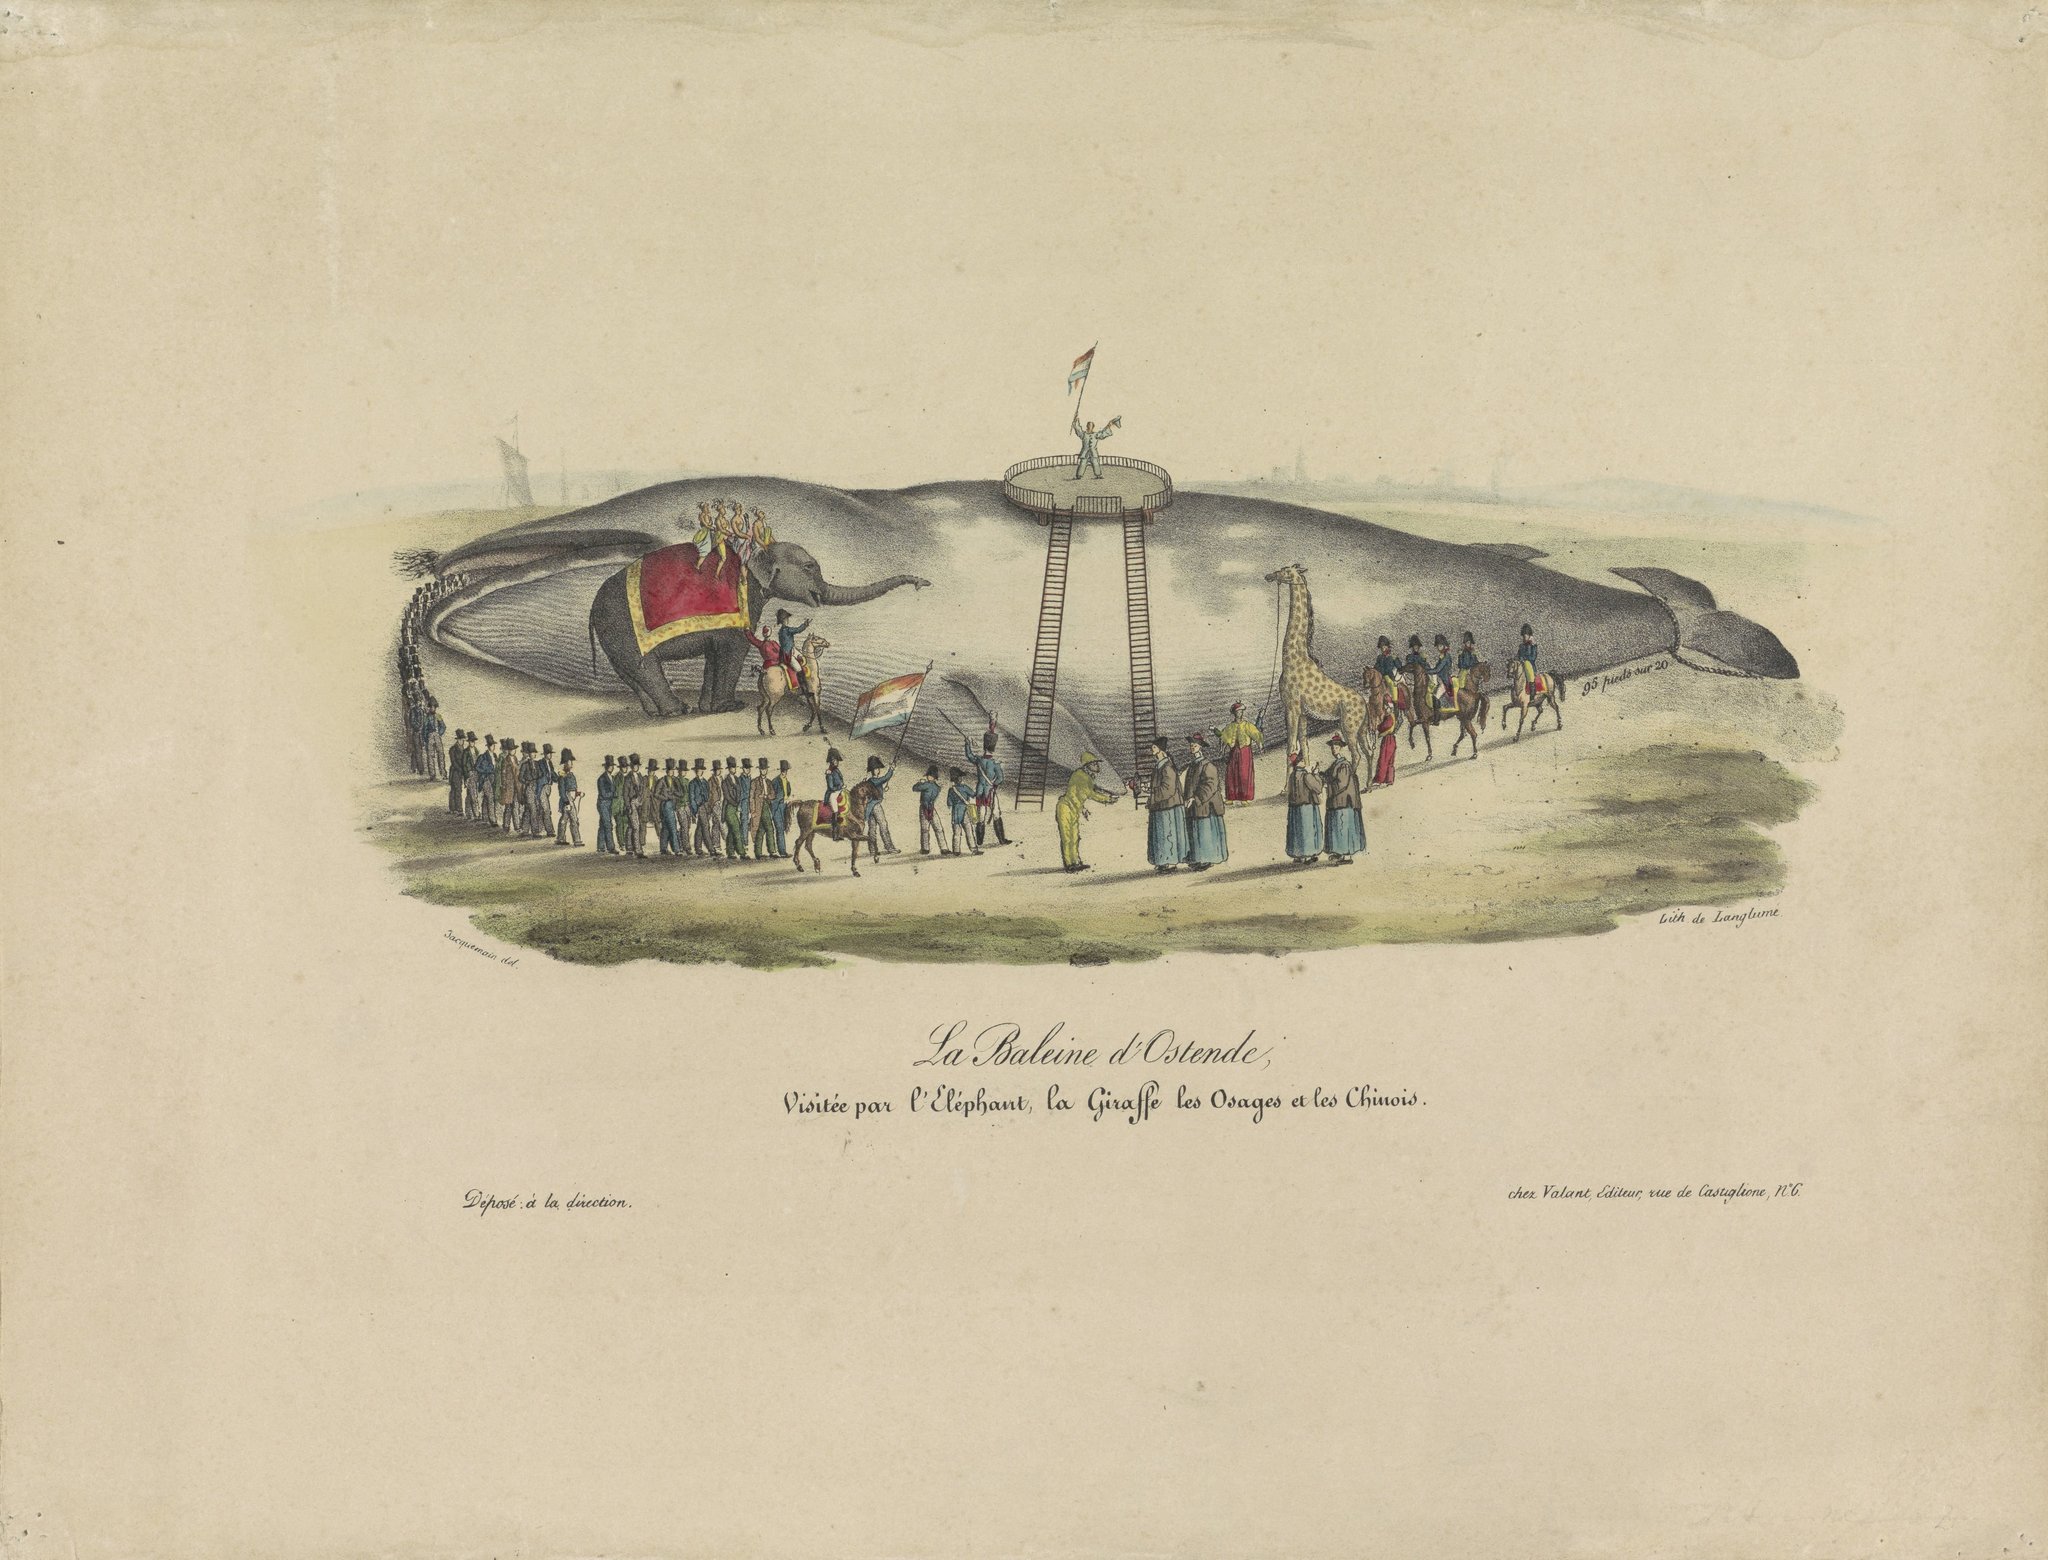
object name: cartoon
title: Kessels en de gestrande walvis van Oostende, 1829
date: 1829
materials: paper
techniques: hand coloring, lithograph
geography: paris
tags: herman kessels, chinese, indigenous peoples of north america (osage), indigenous peoples of north america, swimming mammals: whale (+ dying animal; death of animal; dead animal), hoofed animals: giraffe, trunked animals: elephant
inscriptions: collector's mark: Lugt 2228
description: Spotprent op het rondreizen van Herman Kessels met de te Oostende gestrande walvis, november 1829. Kessels staande bovenop de walvis zwaaiend met een vlag, de vier Osage indianen bekijken de walvis zittend op een olifant, op de voorgrond worden de vier Chinezen ontvangen. Rechts de giraf, links een rij bezoekers.